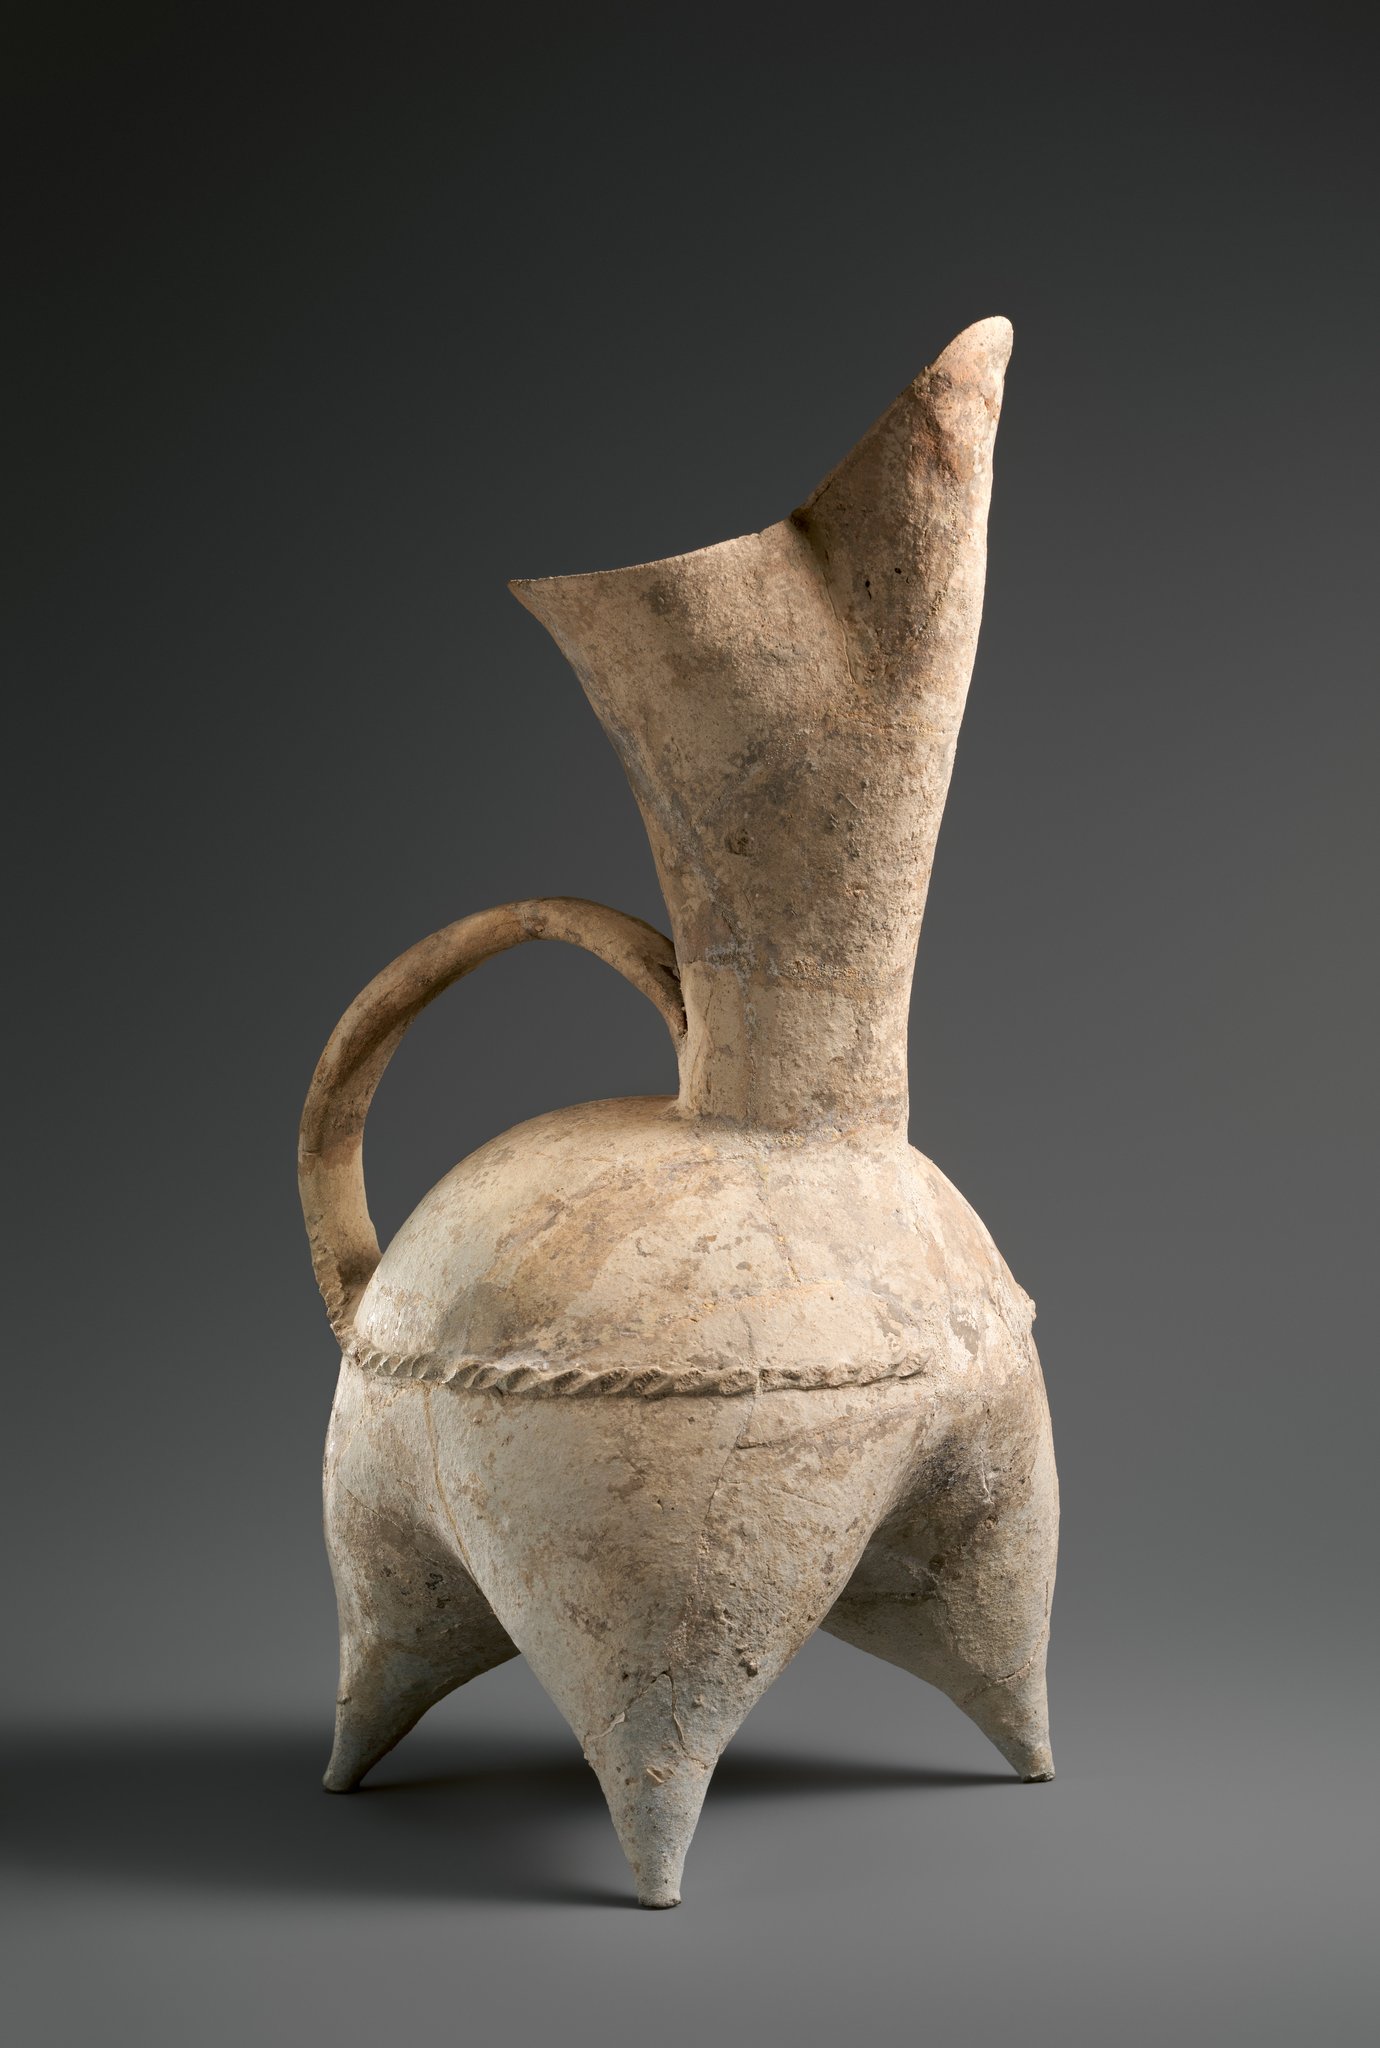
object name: vessel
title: Tripod Vessel (Gui)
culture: chinese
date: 2500 BCE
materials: earthenware